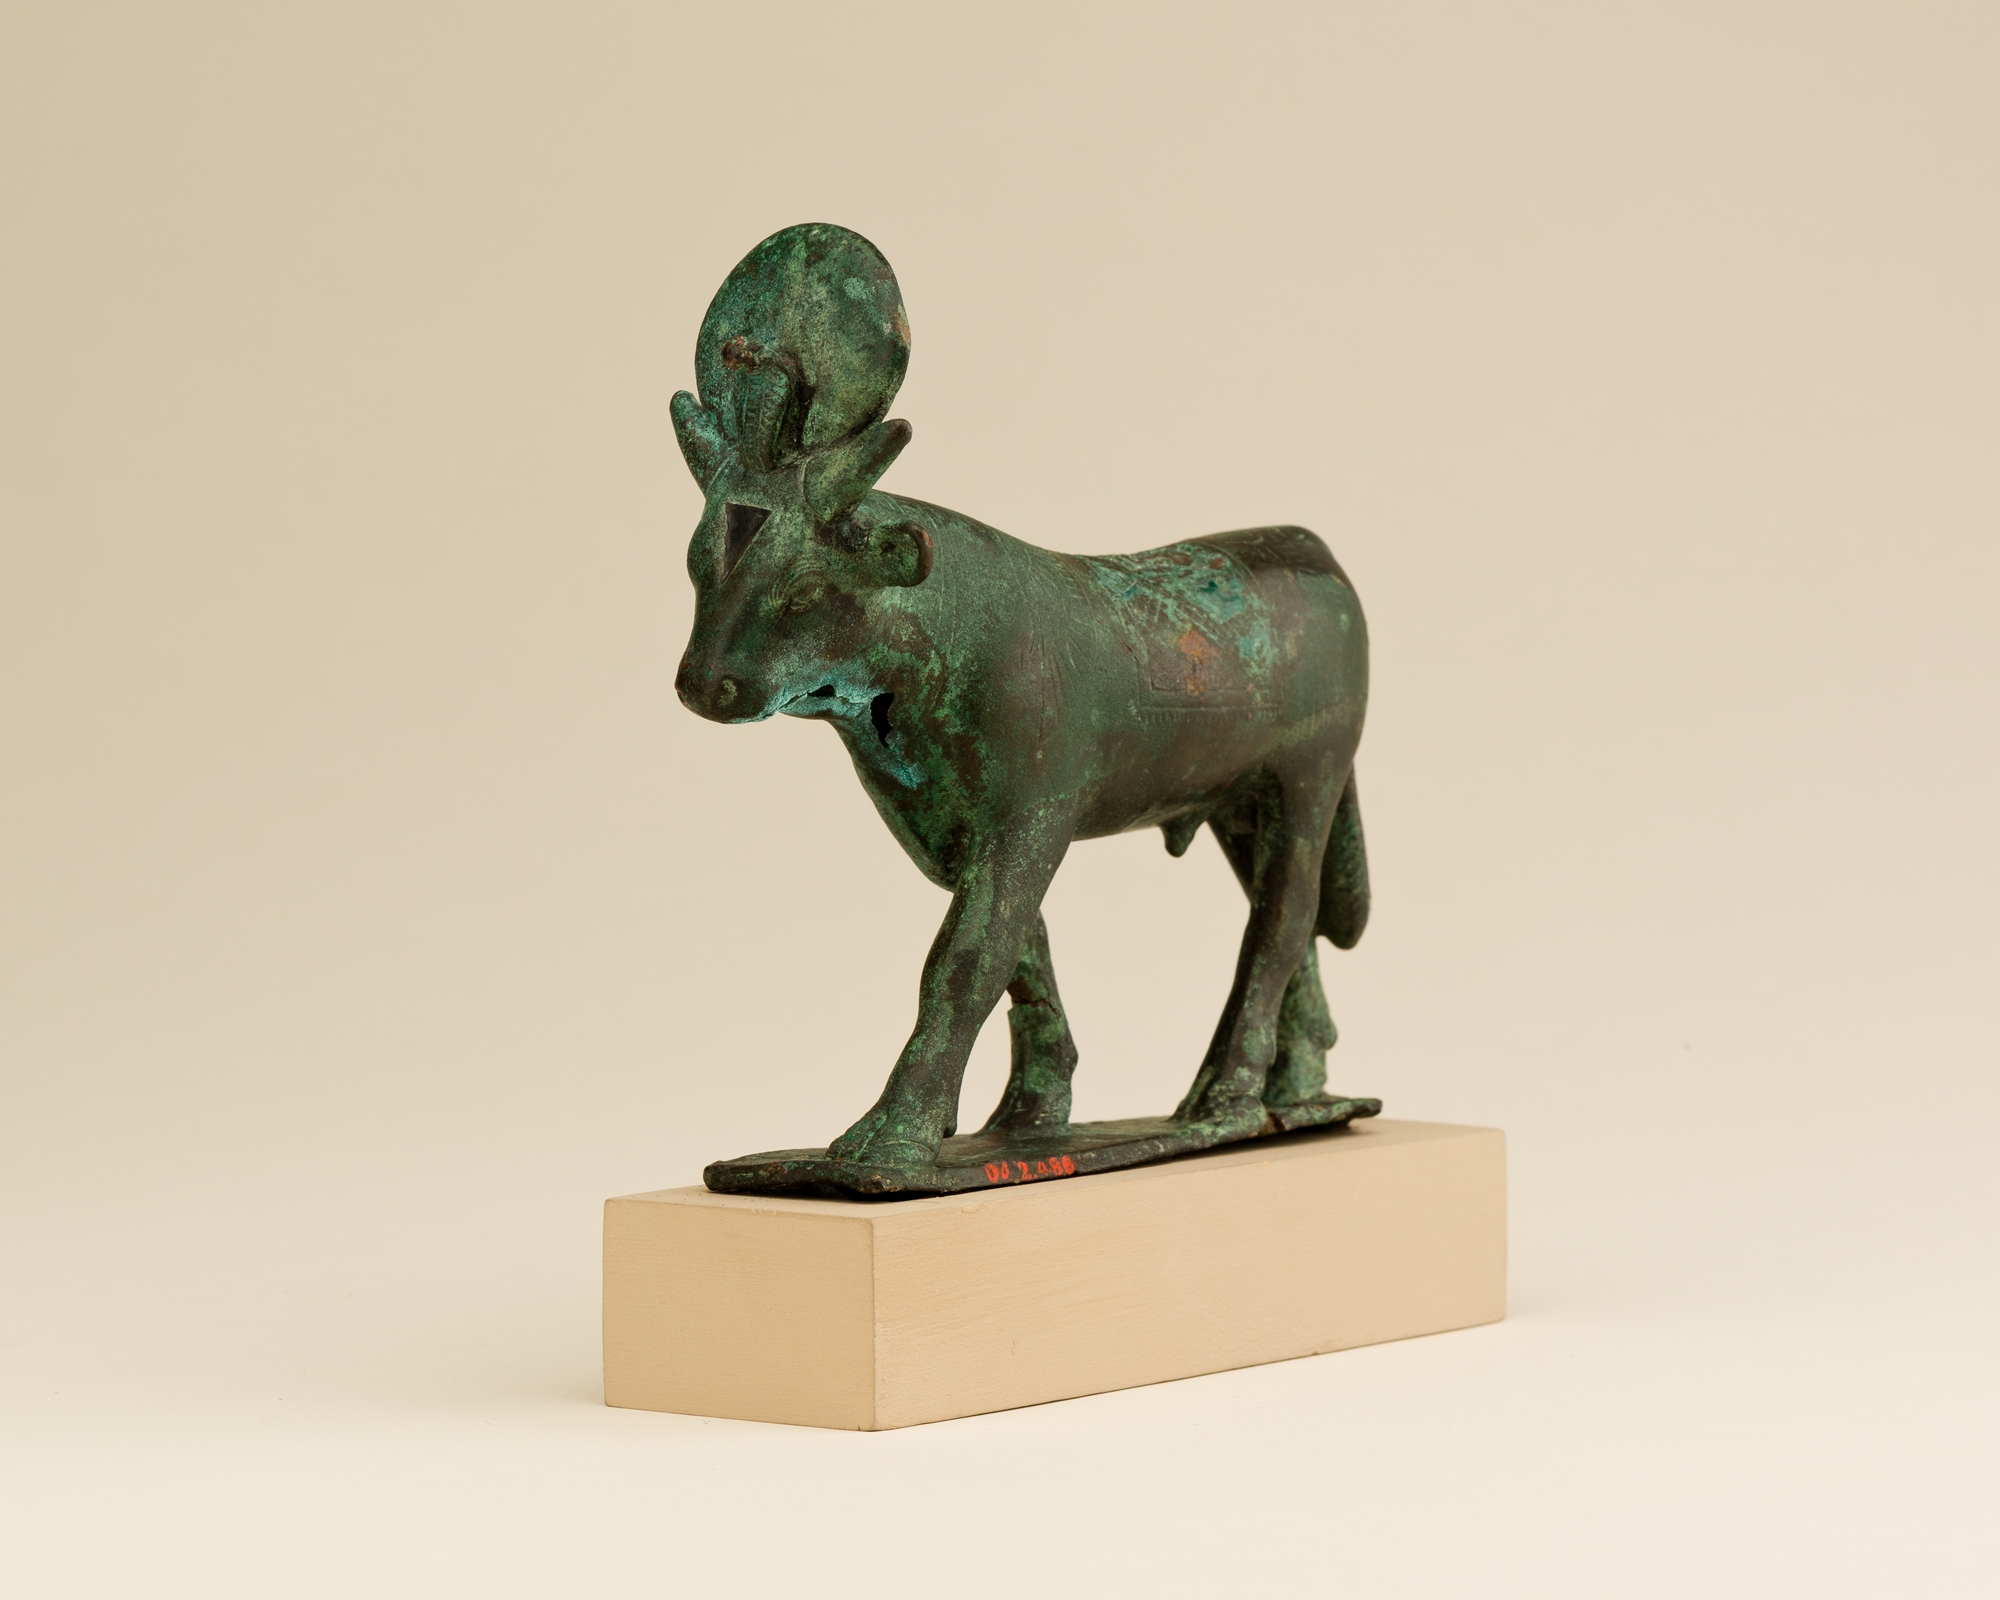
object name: figurine, apis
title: Apis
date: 664-630 BCE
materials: metal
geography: egypt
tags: bulls